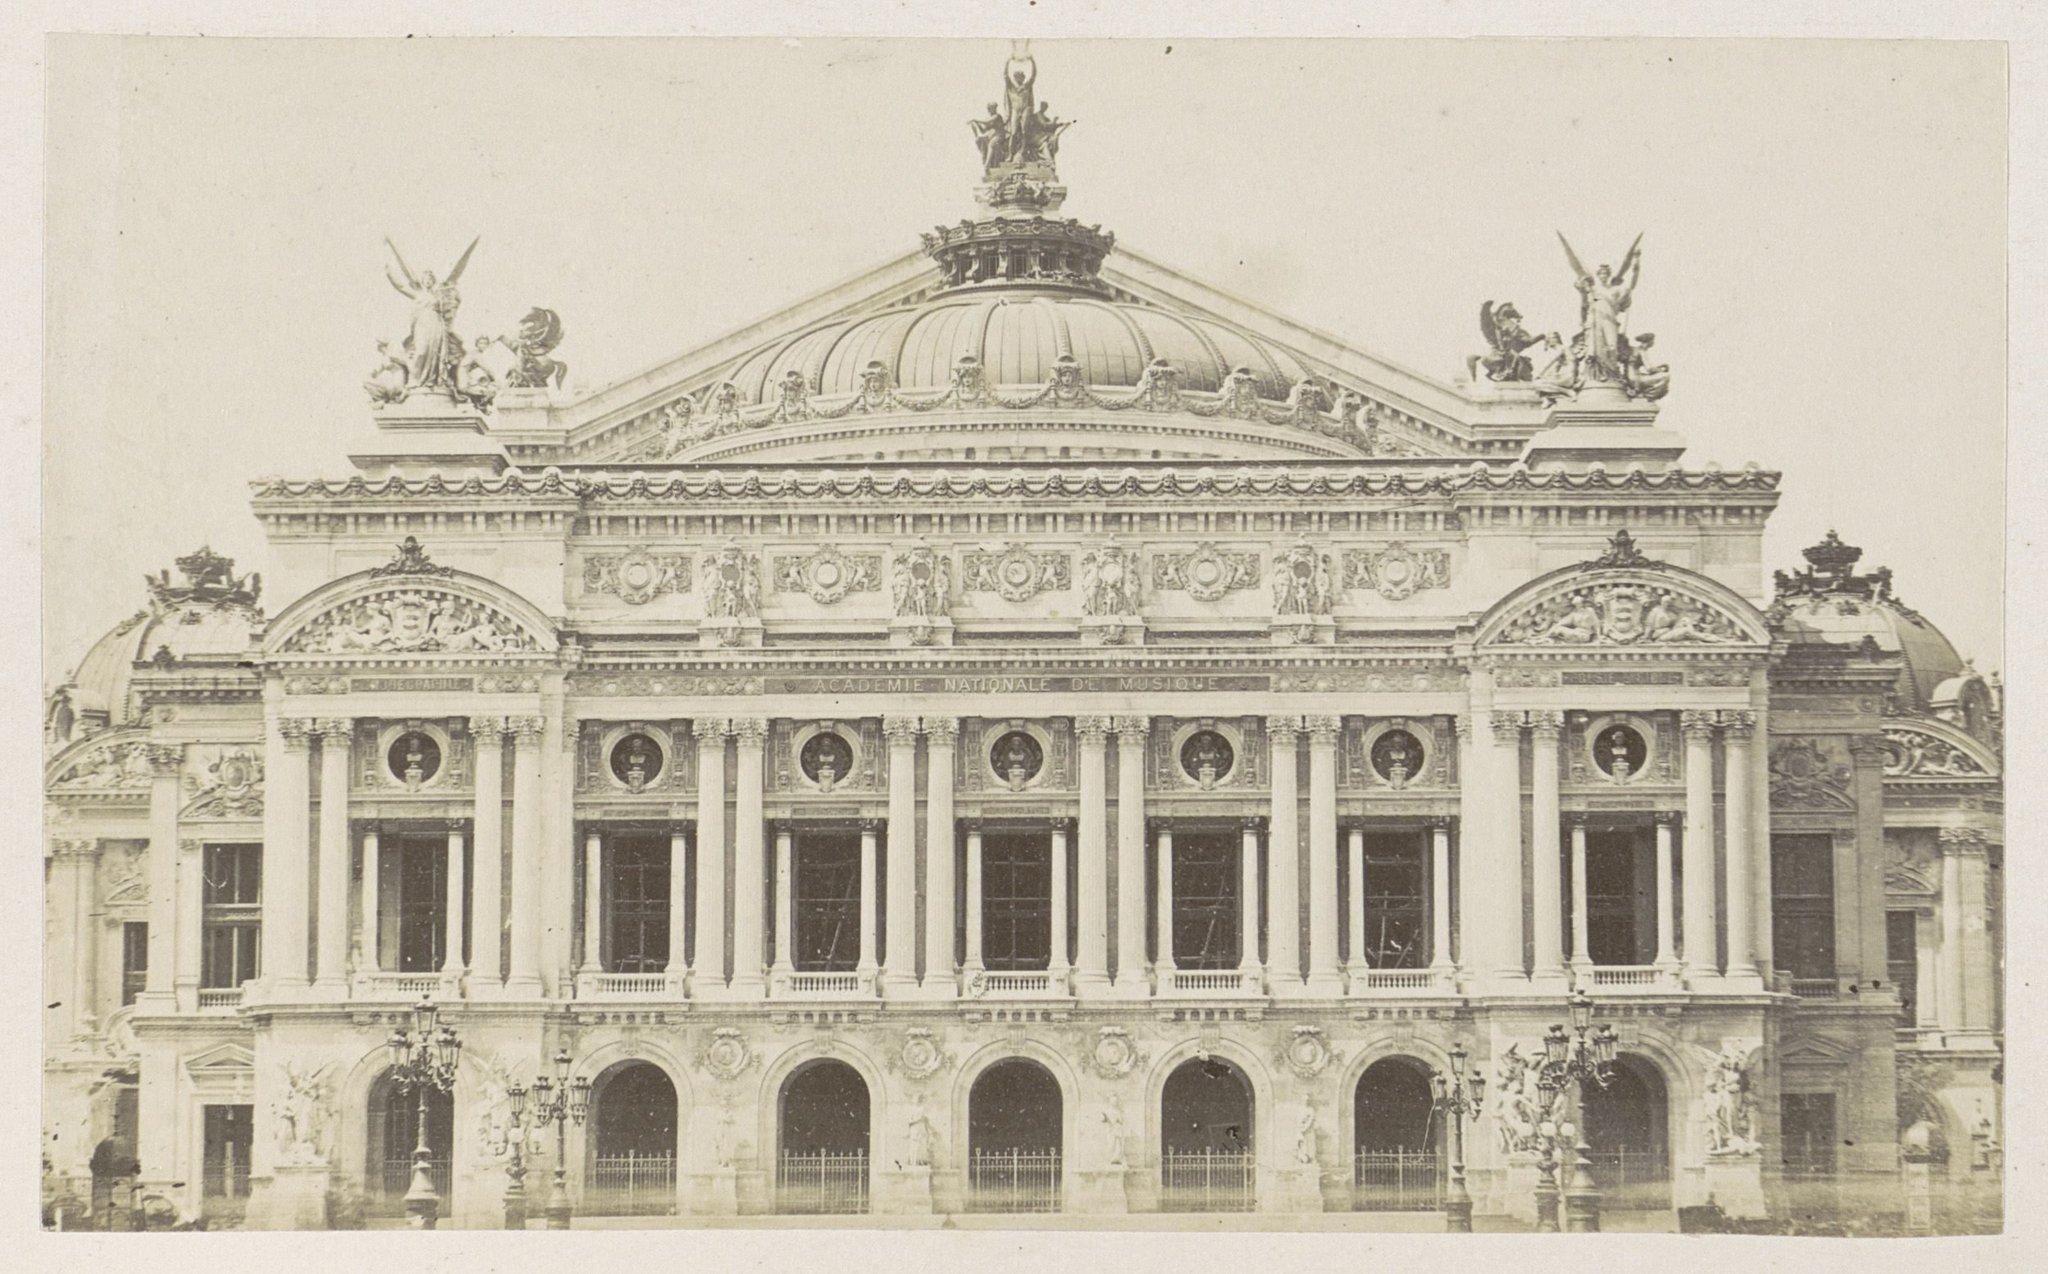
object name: photograph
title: L'Opera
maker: Anonymous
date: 1878-1890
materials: photographic support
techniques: albumen print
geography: paris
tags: façade (of house or building), opera house, paris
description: Onderdeel van Reisalbum Europese steden, vermoedelijk Zweeds.